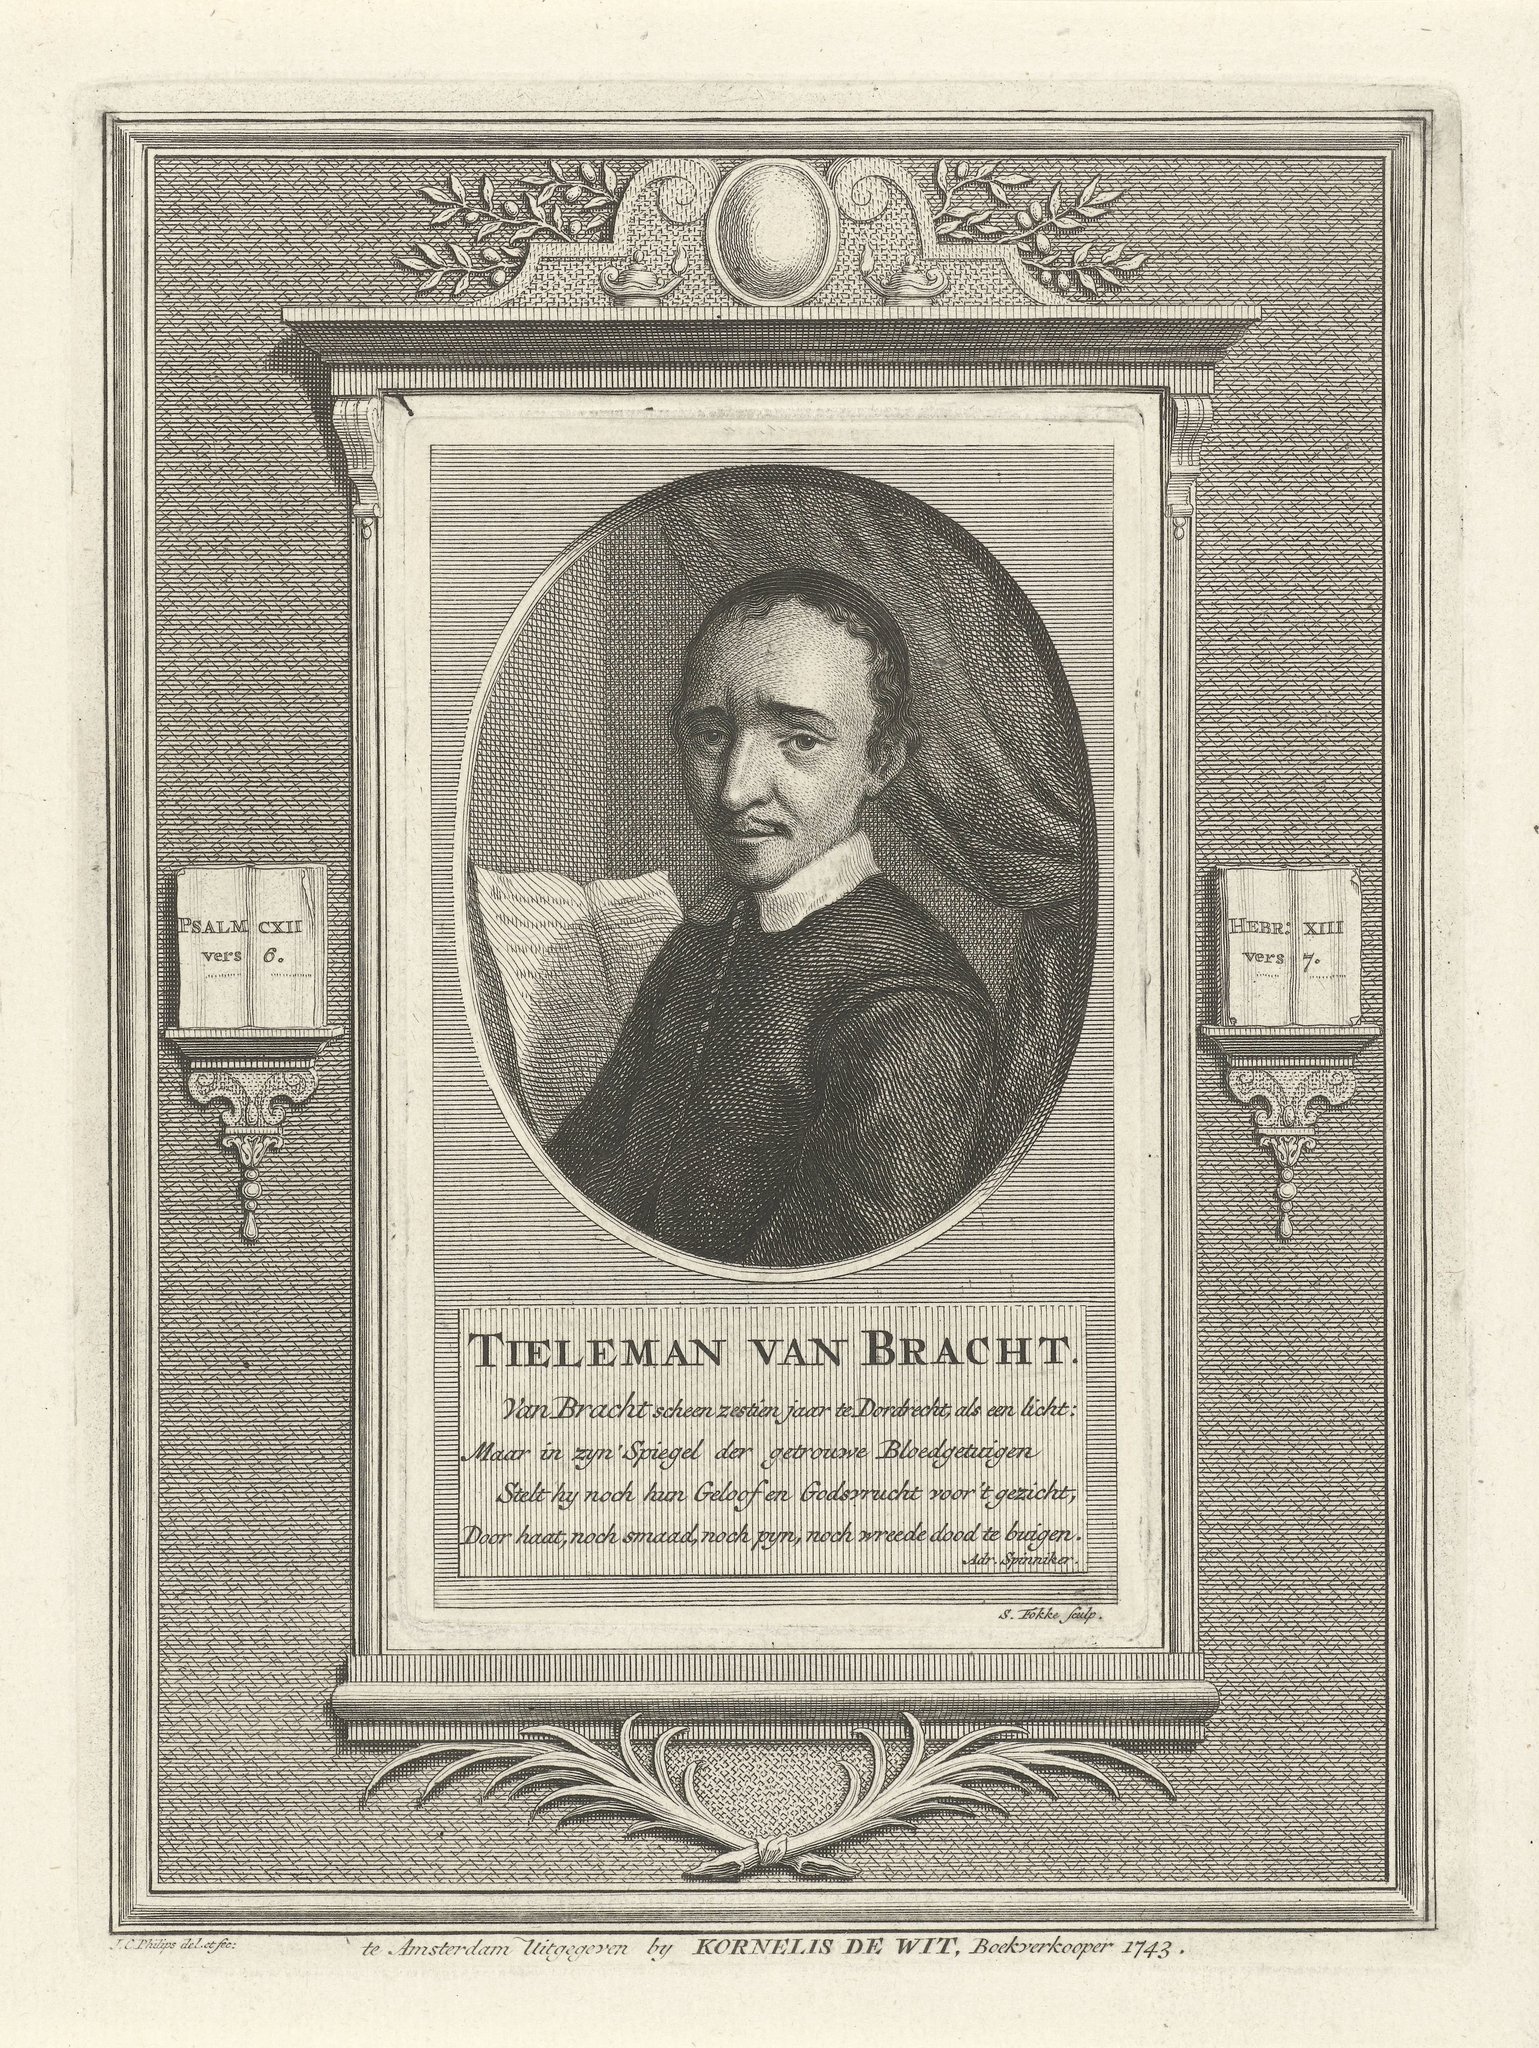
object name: print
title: Portret van Tieleman van Bracht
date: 1743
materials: paper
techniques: engraving, etching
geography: amsterdam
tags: dordrecht, historical person (with name)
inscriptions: collector's mark: Lugt 2228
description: Portretbuste in ovaal van Tieleman van Bracht, naar links. Onder de voorstelling staat zijn naam en een vierregelige tekst in het Nederlands. Het randwerk is afkomstig van een tweede plaat en vervaardigd door prentmaker Jan Caspar Philips.